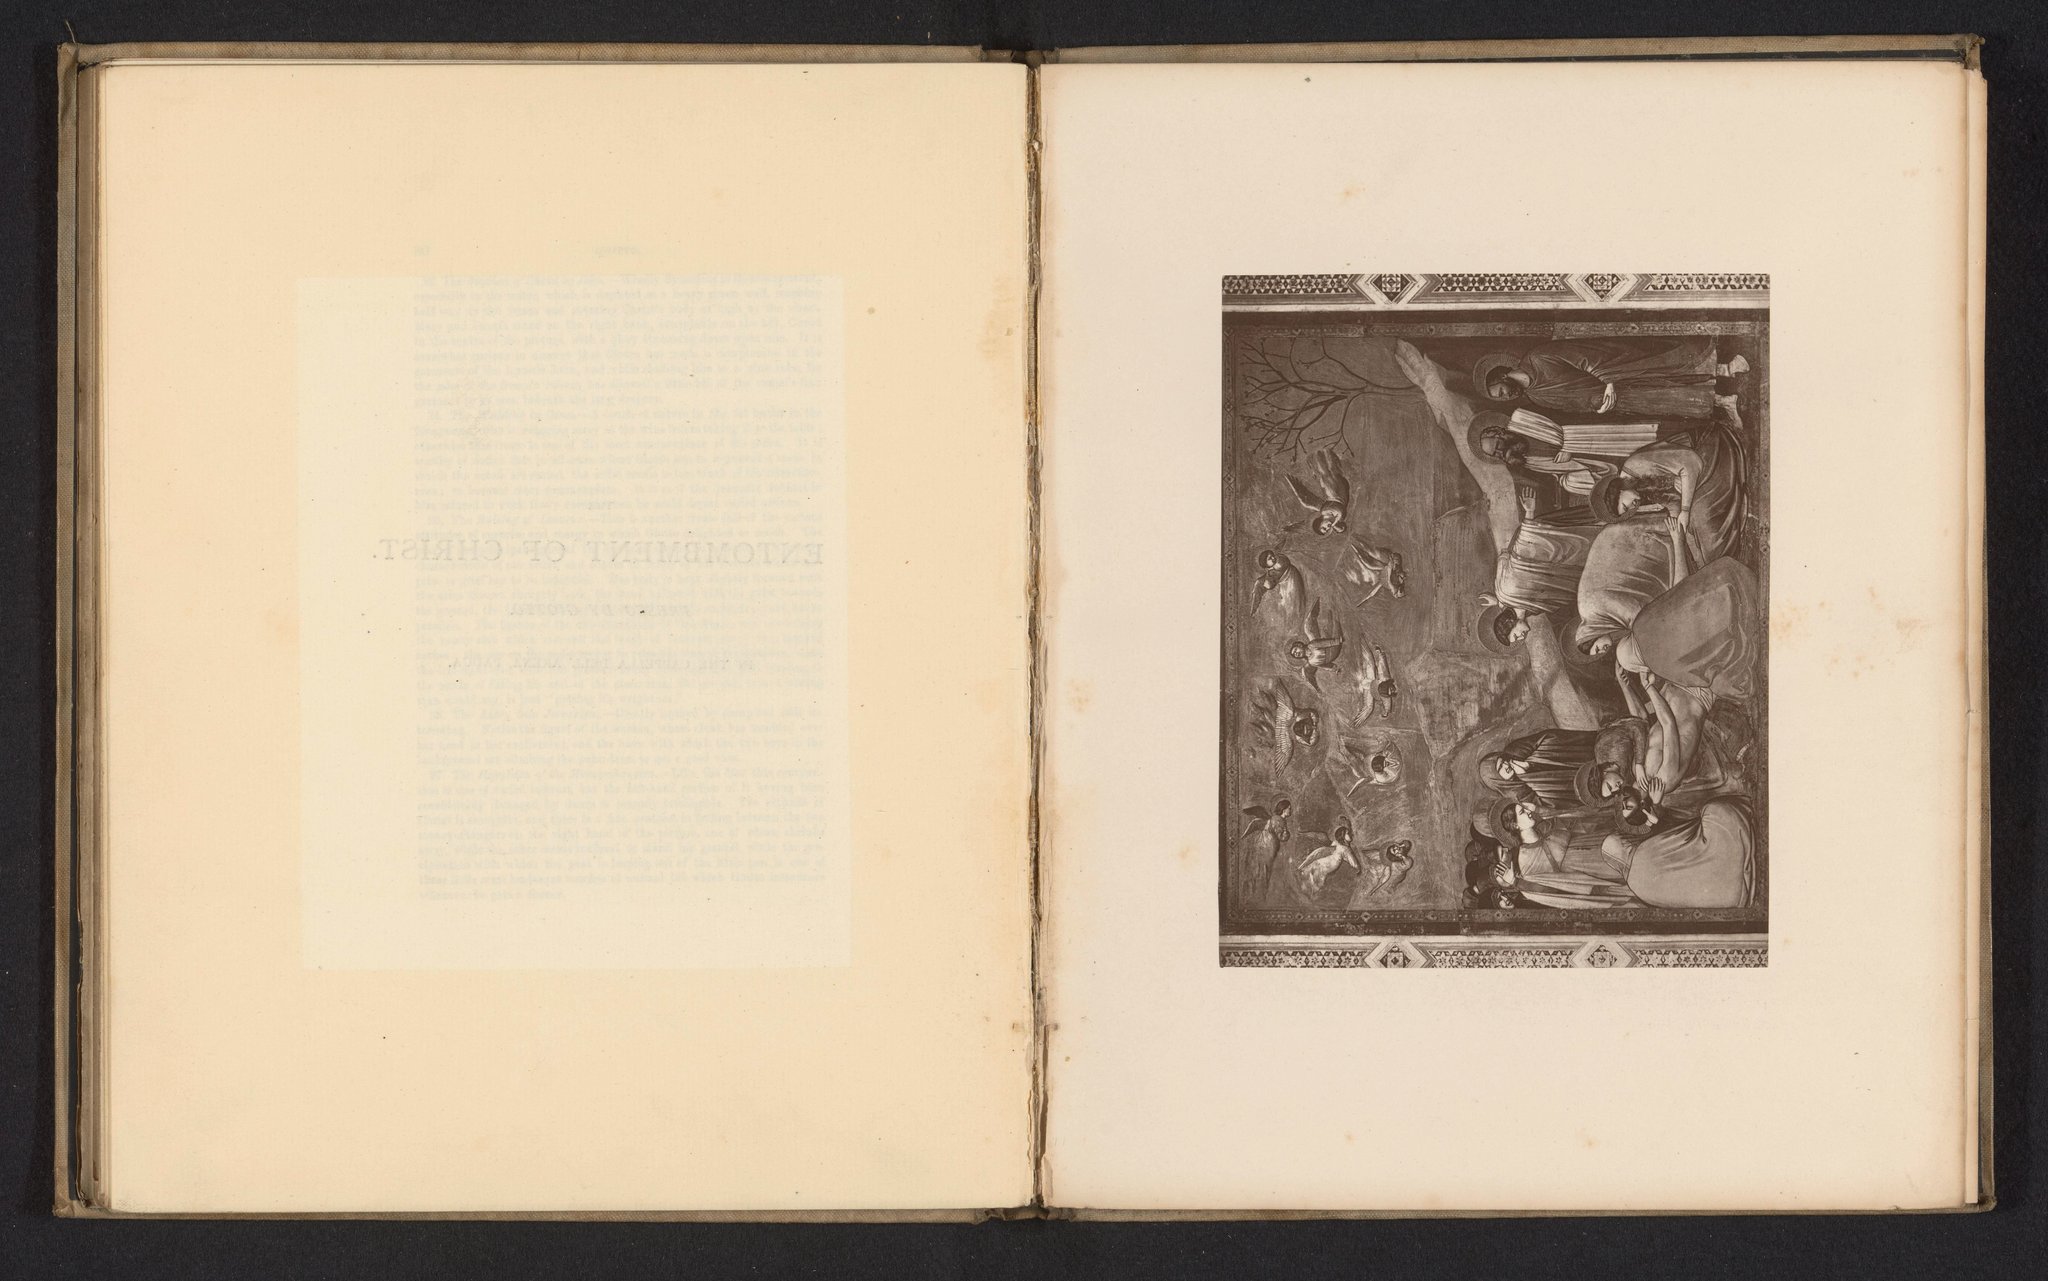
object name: reproduction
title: Fotoreproductie van een fresco, voorstellende de bewening van Christus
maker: Anonymous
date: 1870-1880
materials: paper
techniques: woodburytype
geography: padua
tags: lamentation over the dead christ by his relatives and friends (christ usually without crown of thorns)